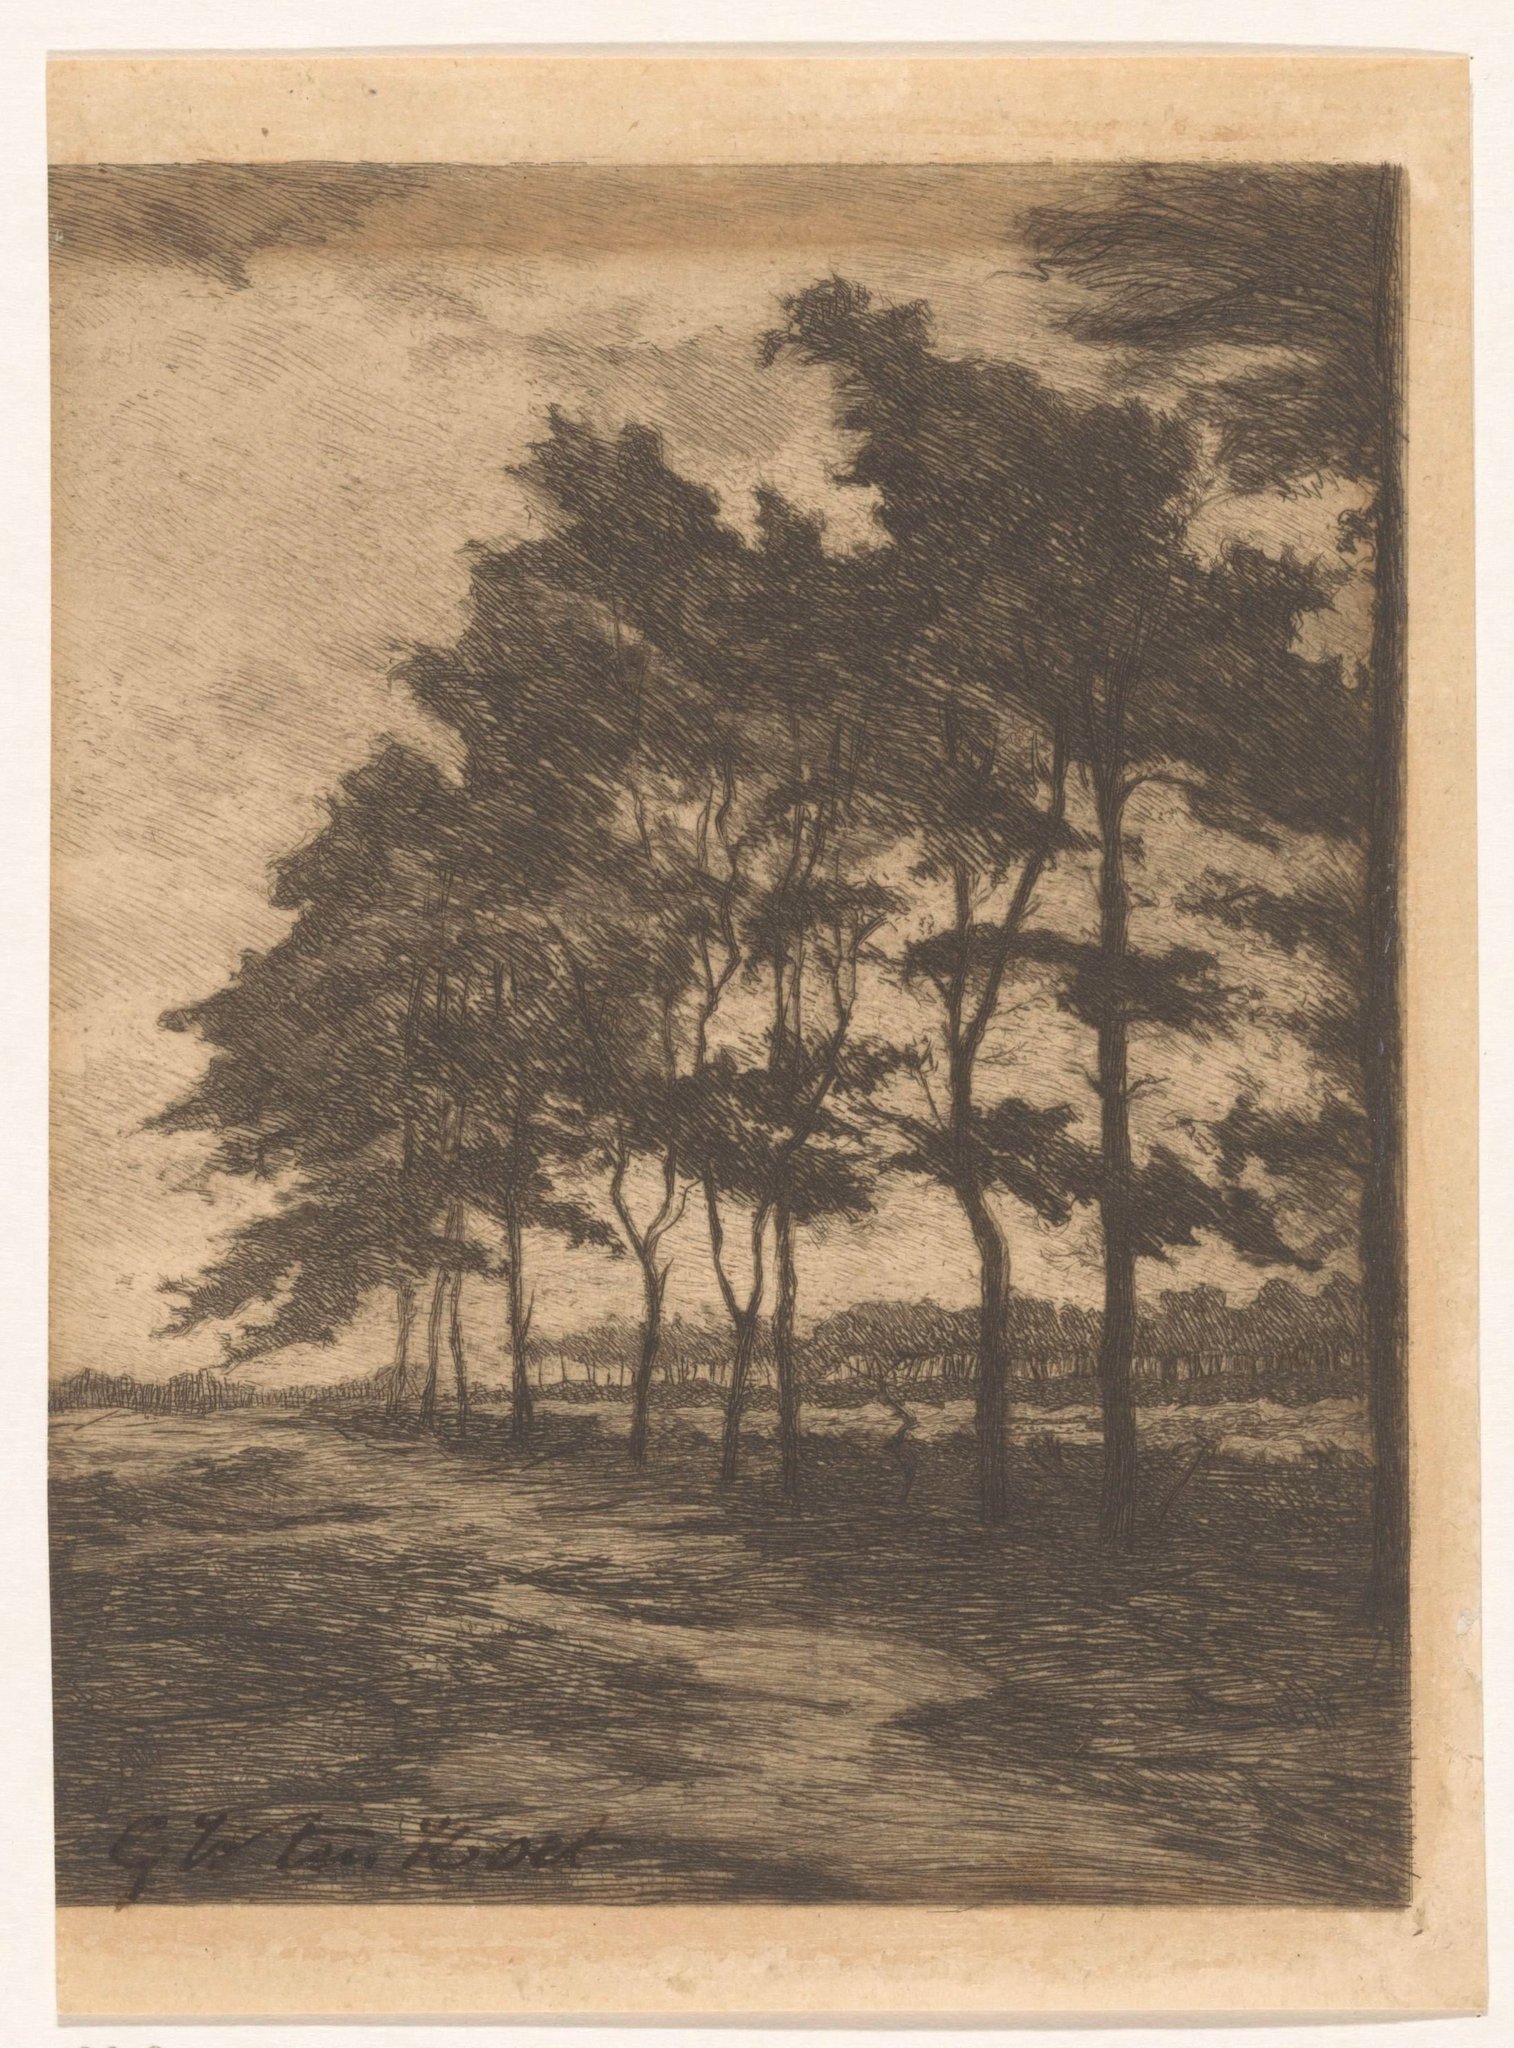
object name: print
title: Bomenrij in heidelandschap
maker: gerarda wilhelmina ten hoet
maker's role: print maker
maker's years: 1857-1939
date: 1867-1937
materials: paper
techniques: etching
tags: trees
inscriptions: collector's mark: Lugt 2760, collector's mark: Lugt 2228